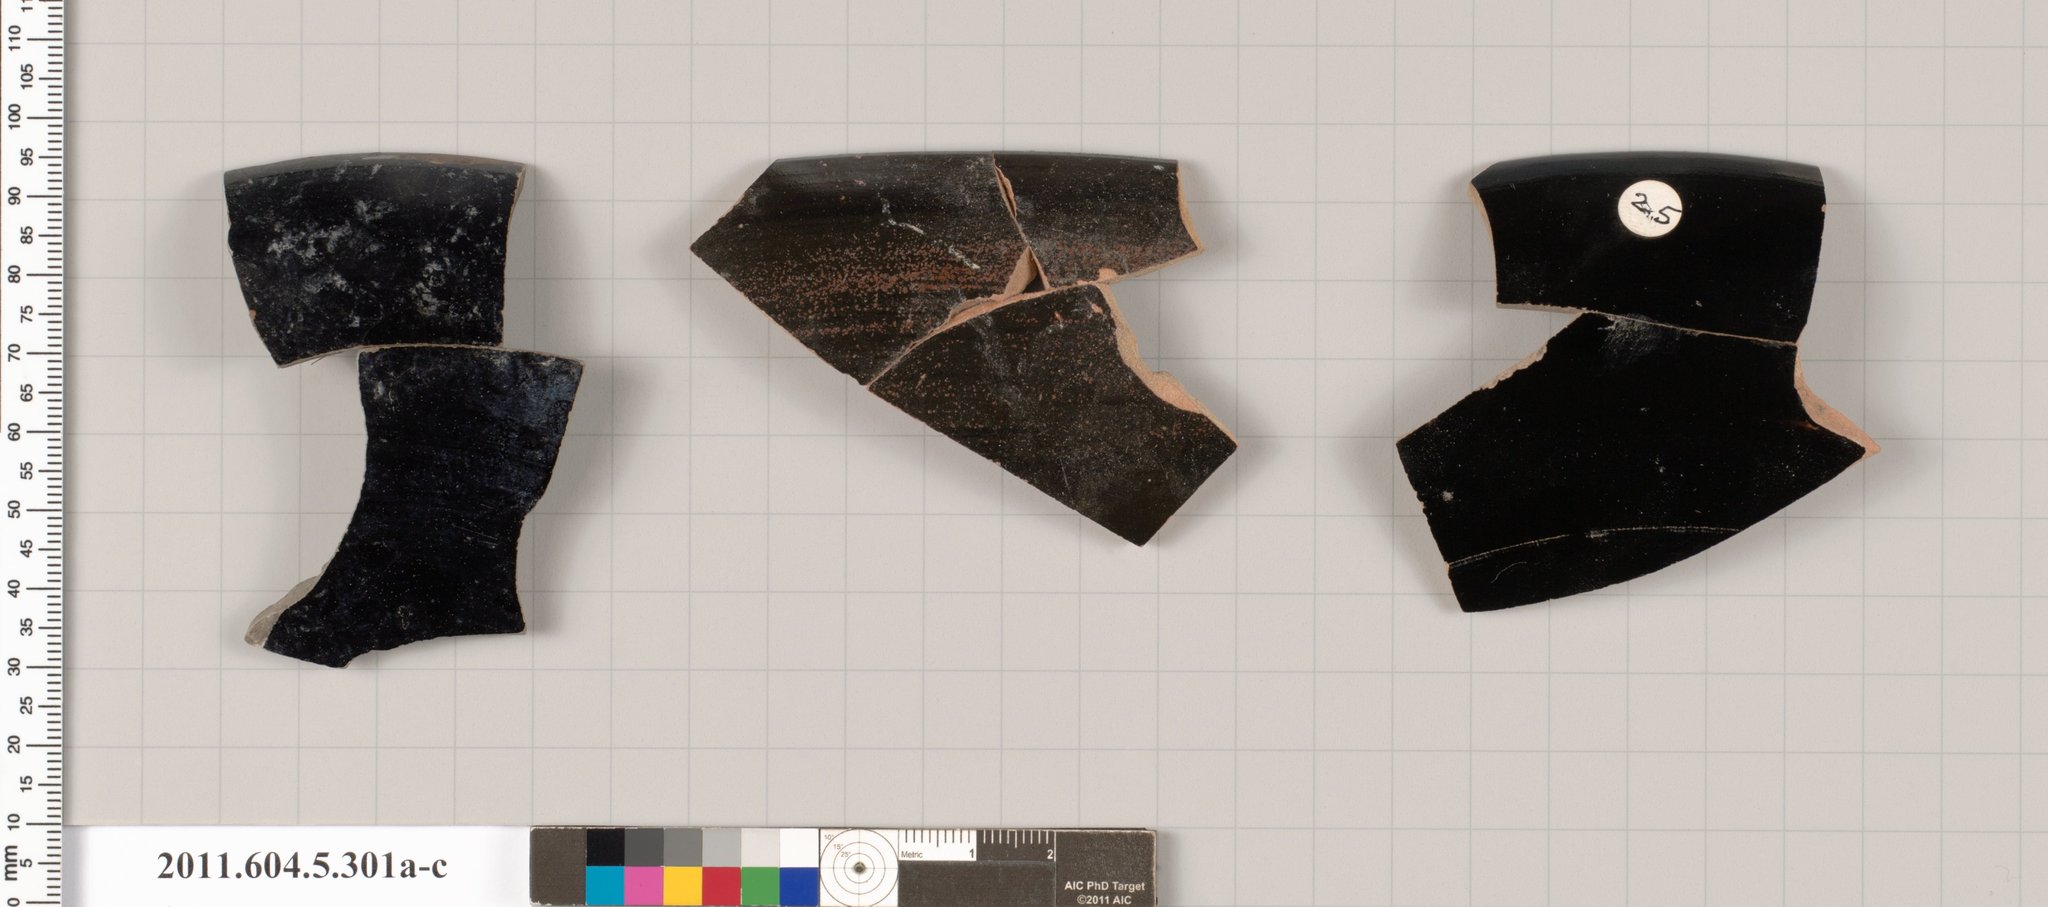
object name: kylix fragment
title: Terracotta rim fragments of kylikes (drinking cups)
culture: greek, attic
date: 600-401 BCE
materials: terracotta